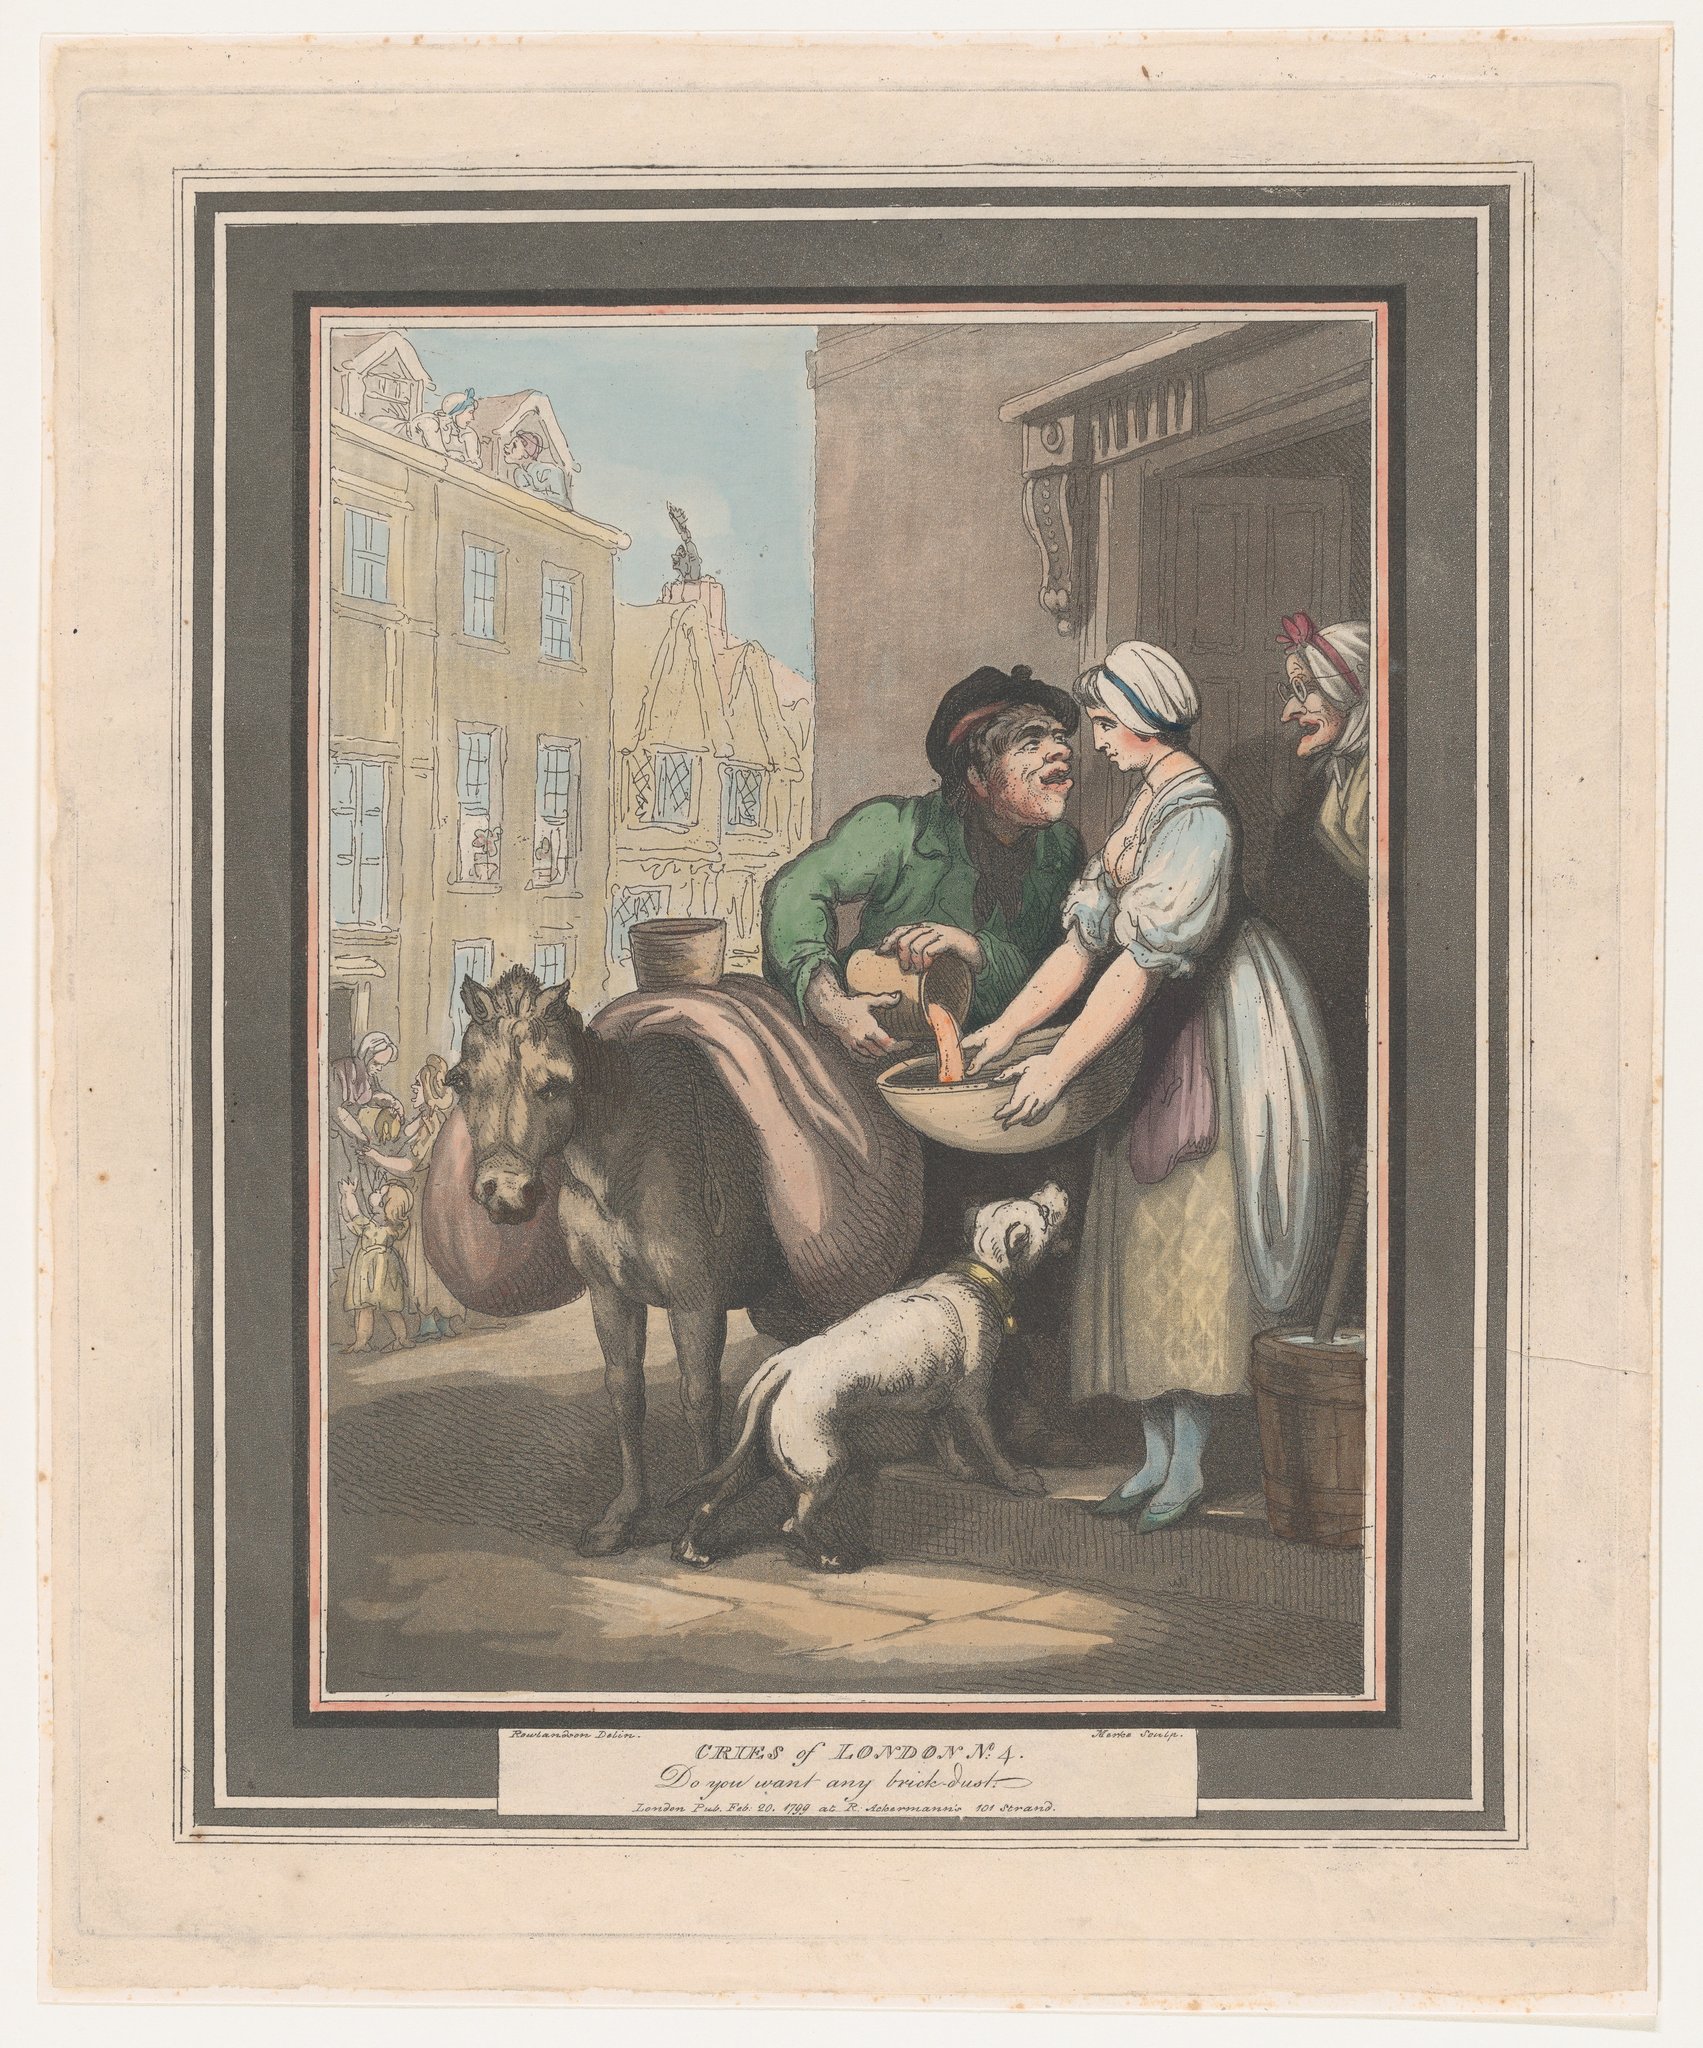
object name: print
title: Cries of London, No. 4: Do You Want Any Brickdust?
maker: henri merke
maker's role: artist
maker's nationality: swiss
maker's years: 1760-1820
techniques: aquatint, etching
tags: men,women,dogs,donkeys